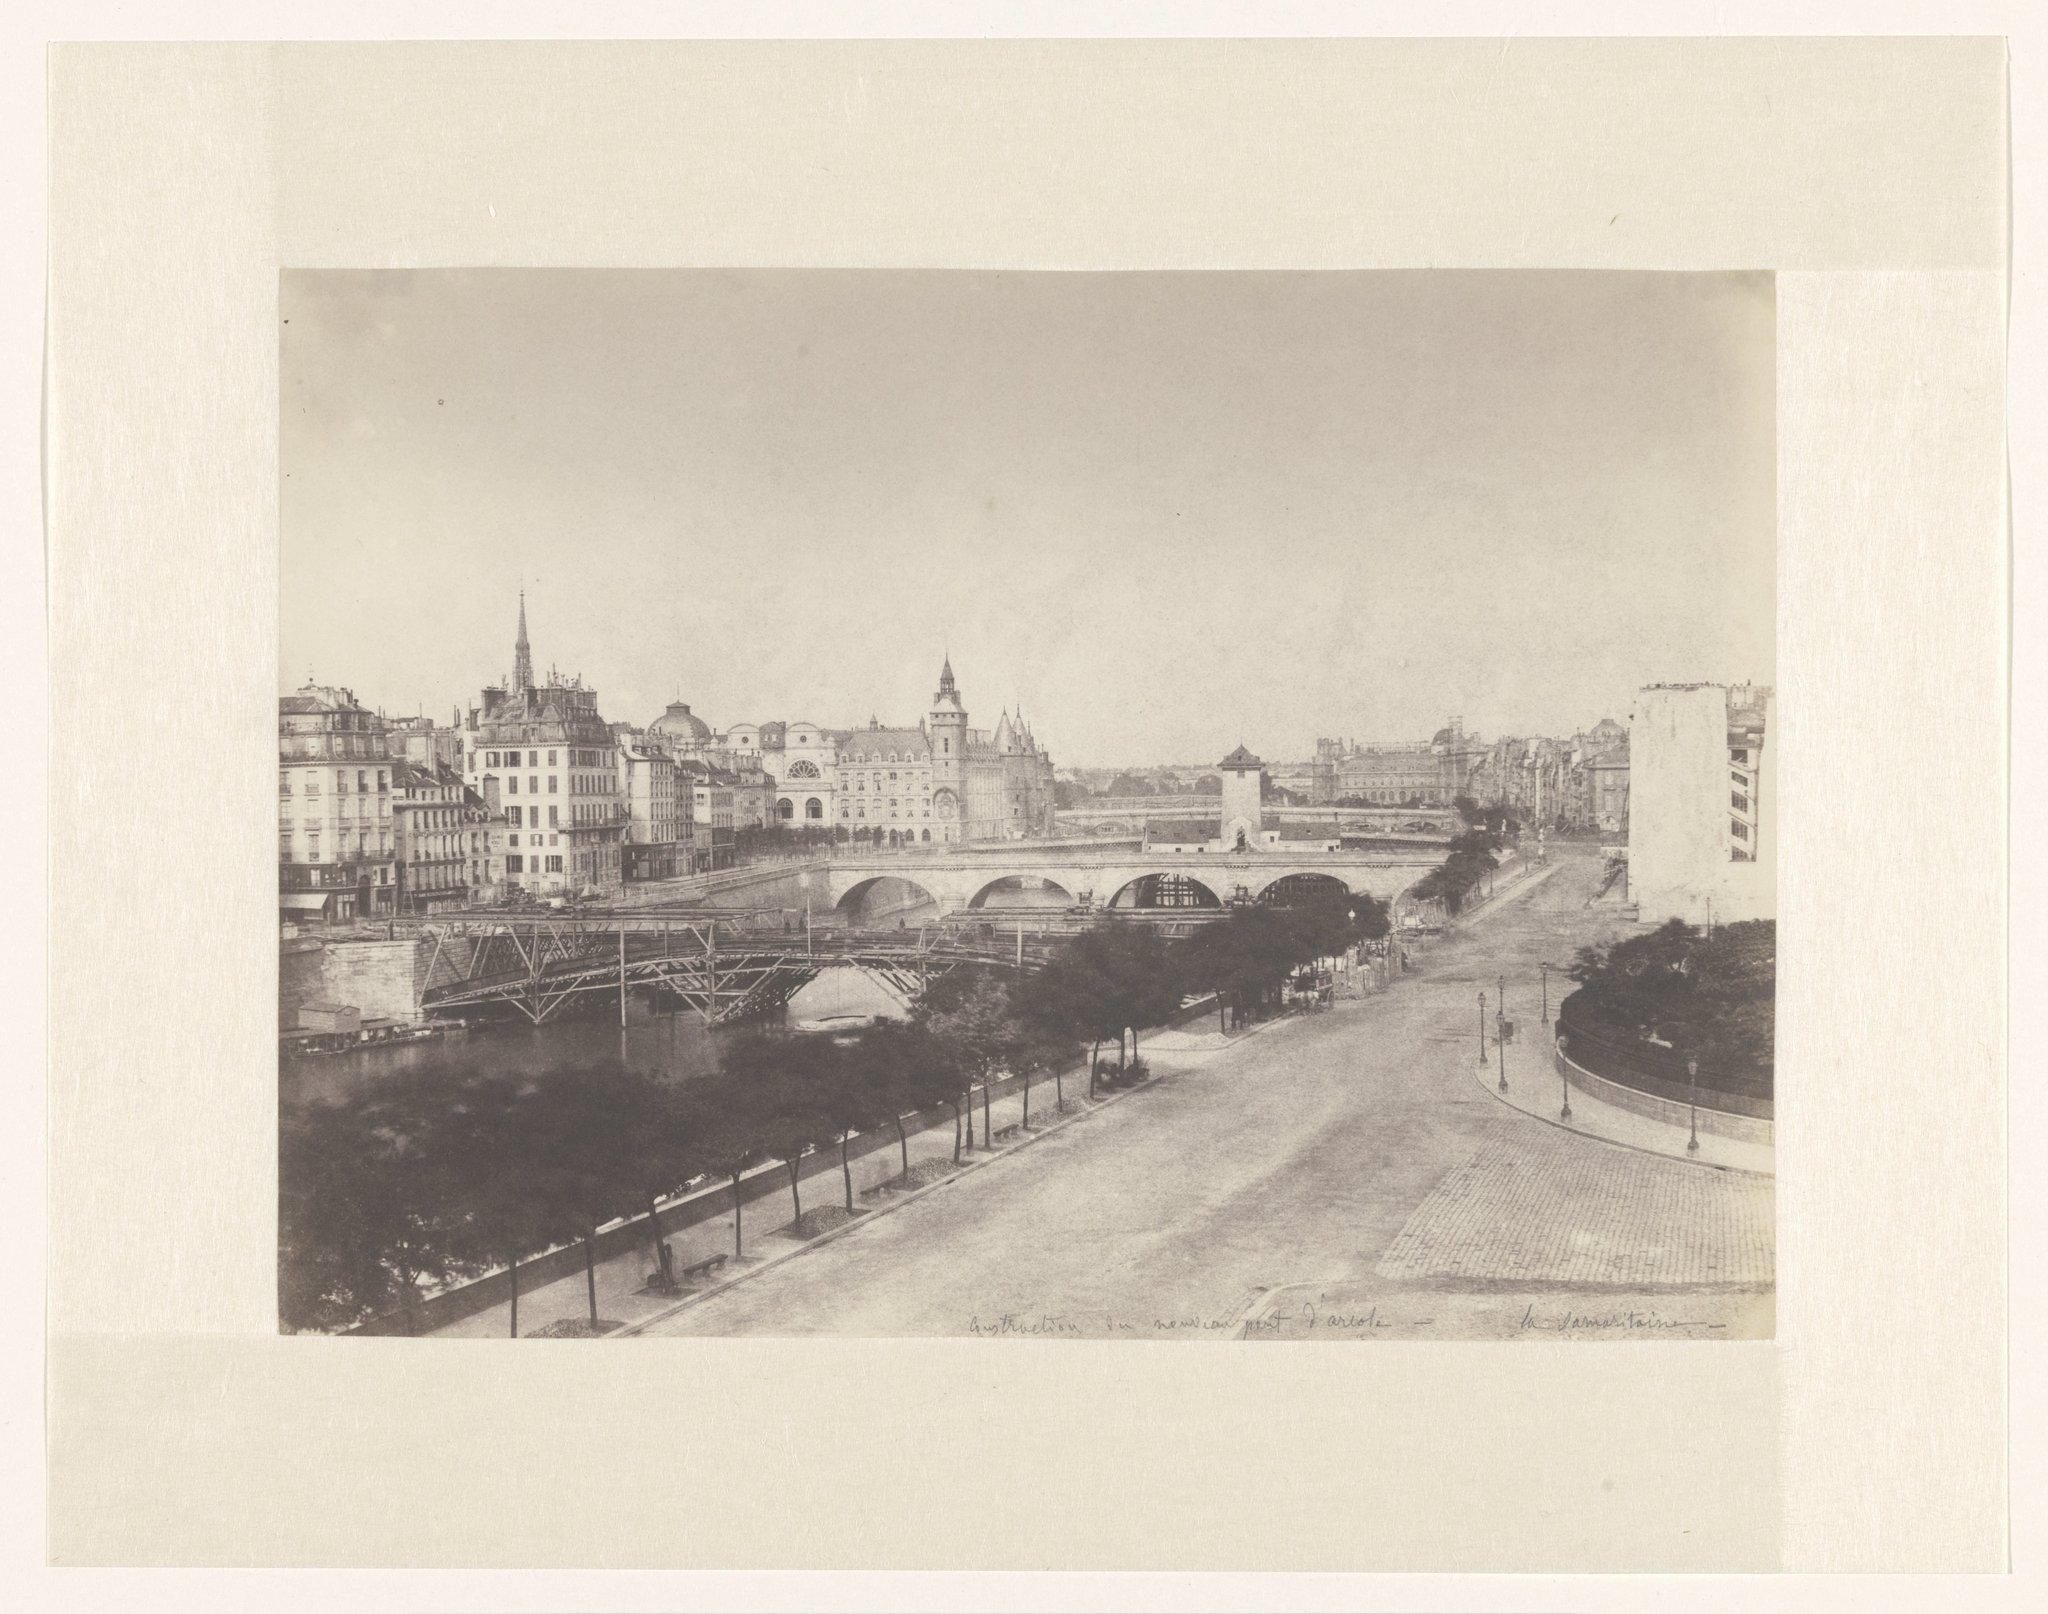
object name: photograph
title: Construction du nouveau pont d'arcole - la samaritaine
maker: charles nègre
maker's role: fotograaf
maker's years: 1820-1880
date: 1855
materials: cardboard, paper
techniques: salted paper print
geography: paris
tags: bridge, bridge in city across river, canal, etc.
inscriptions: inscription: ‘H-34/ No 129’, inscription: ‘construction du nouveau pont d'arcole - la samaritaine’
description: Gezien vanaf het Hôtel-de-Ville, met op de achtergrond de Conciergerie en de Pont au Change.